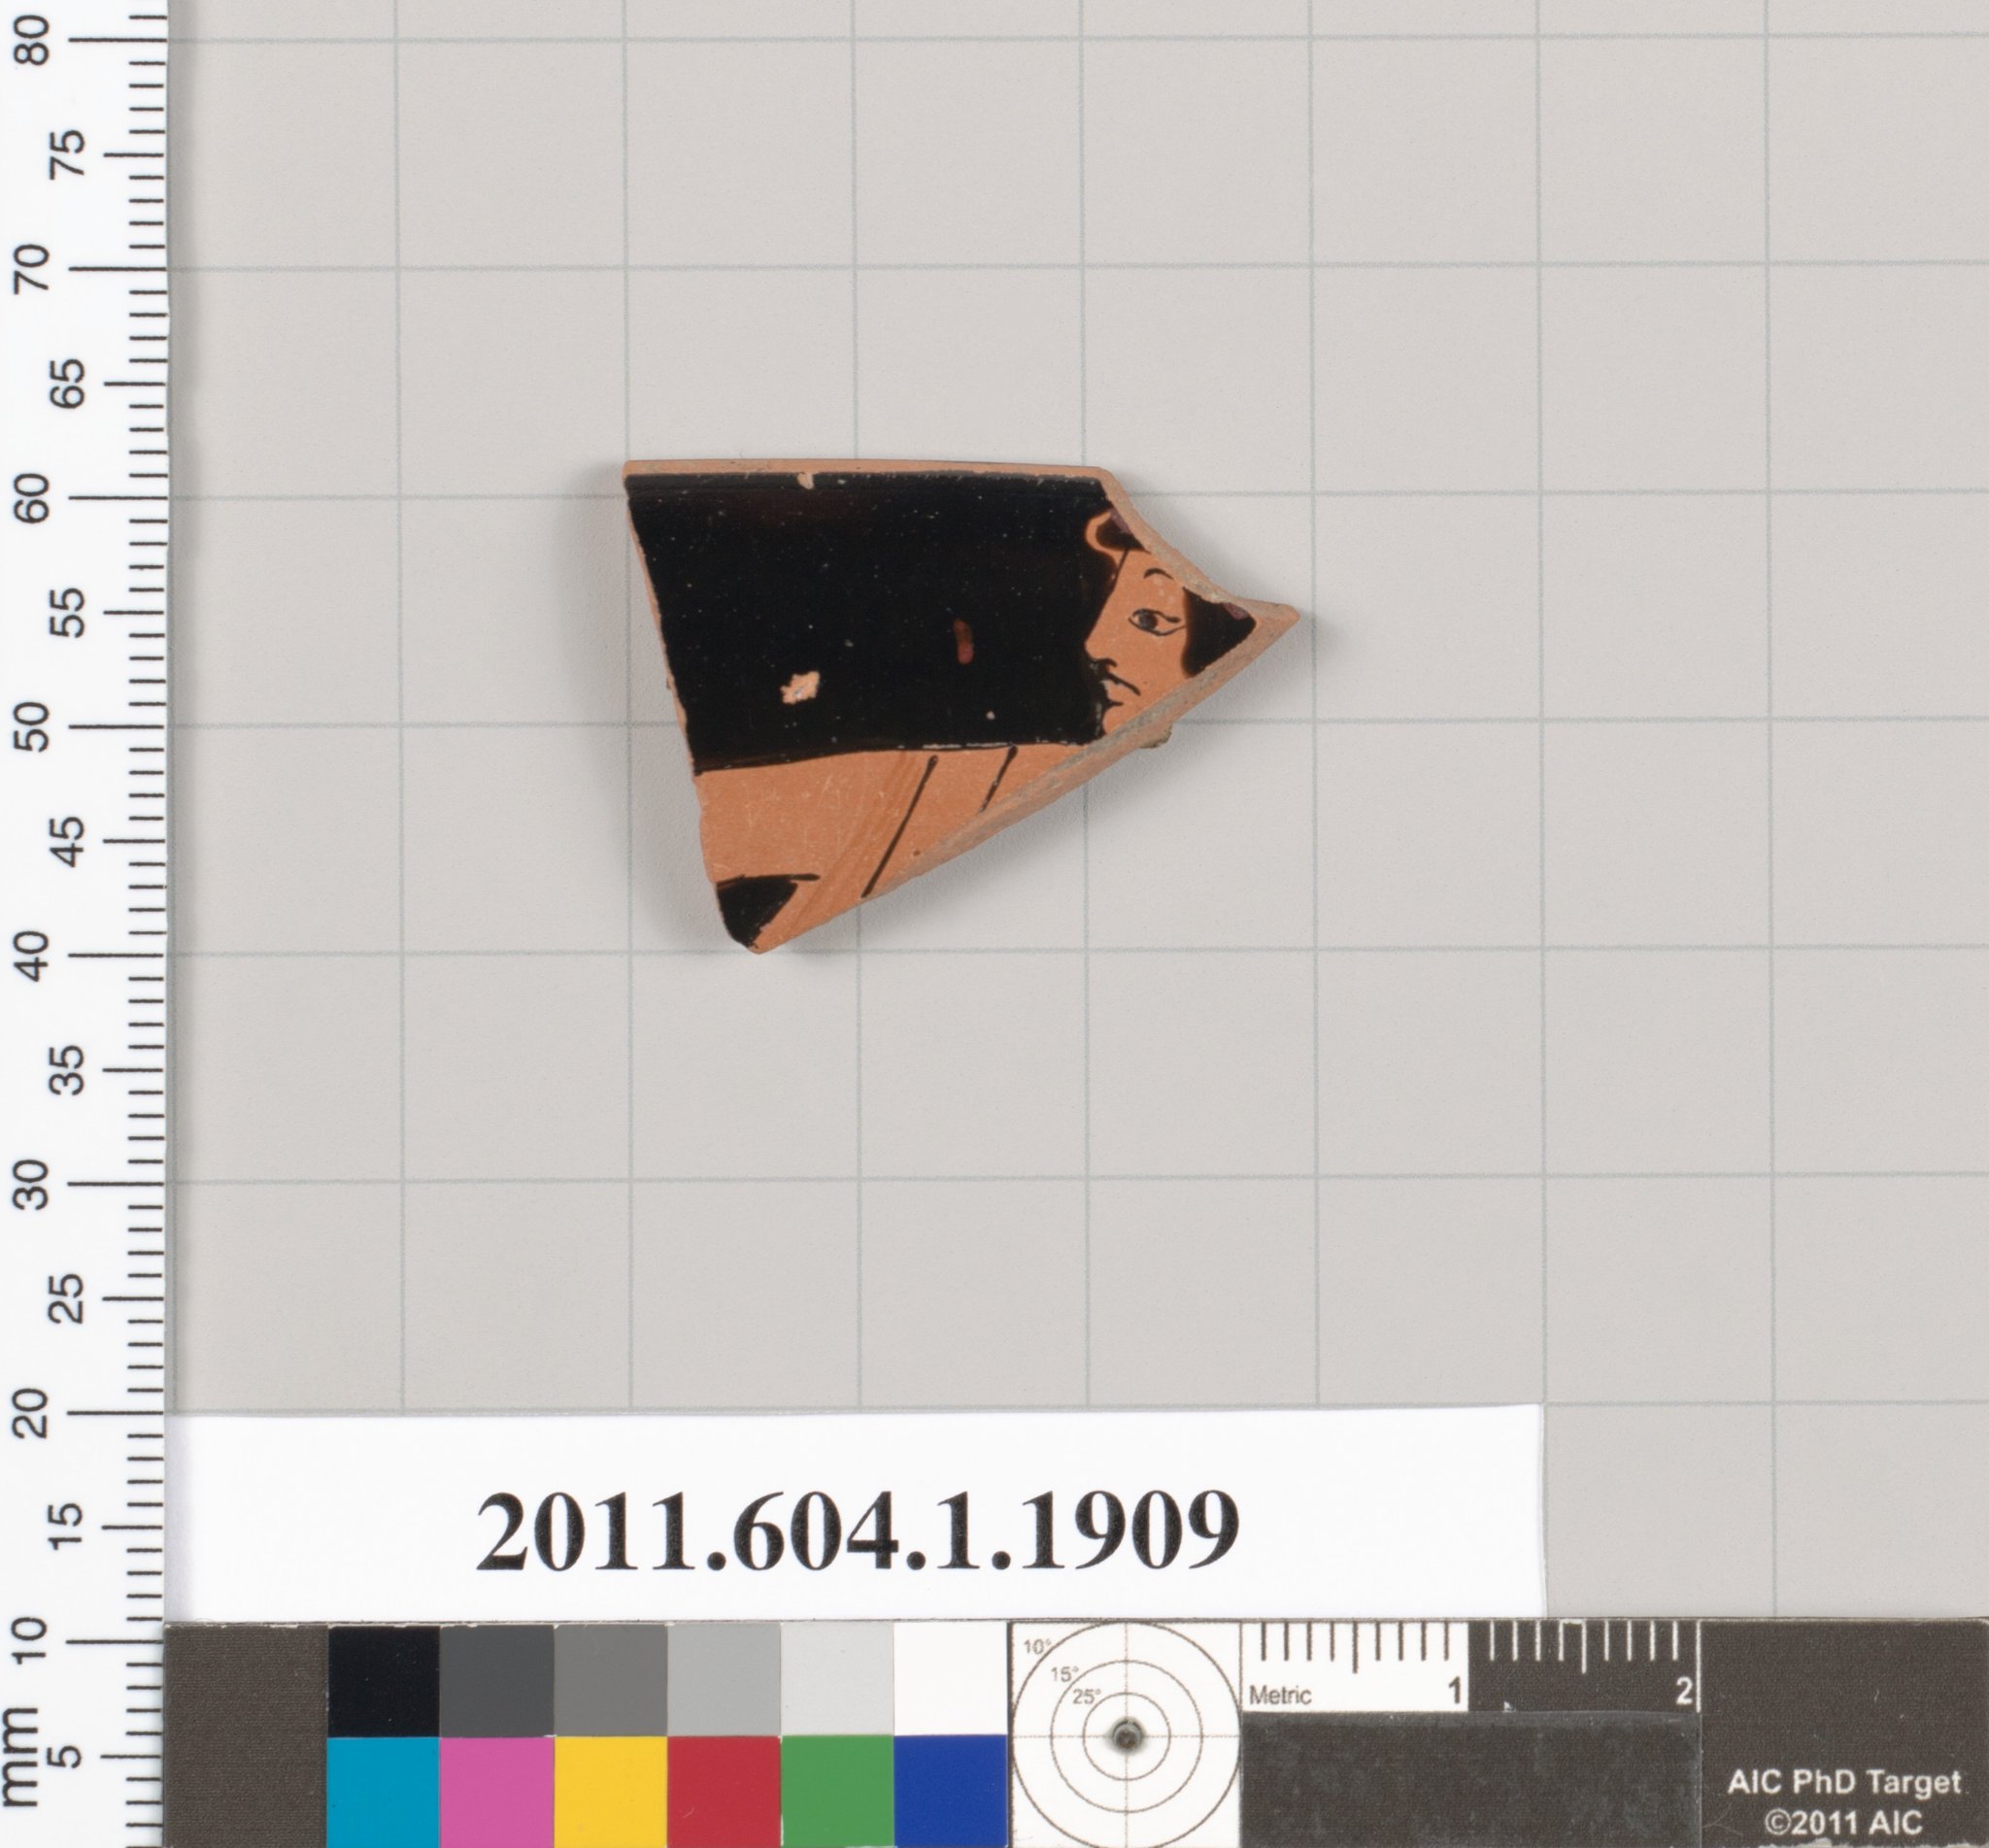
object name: kylix fragment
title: Terracotta rim fragment of a kylix (drinking cup)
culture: greek, attic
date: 534-468 BCE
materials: terracotta